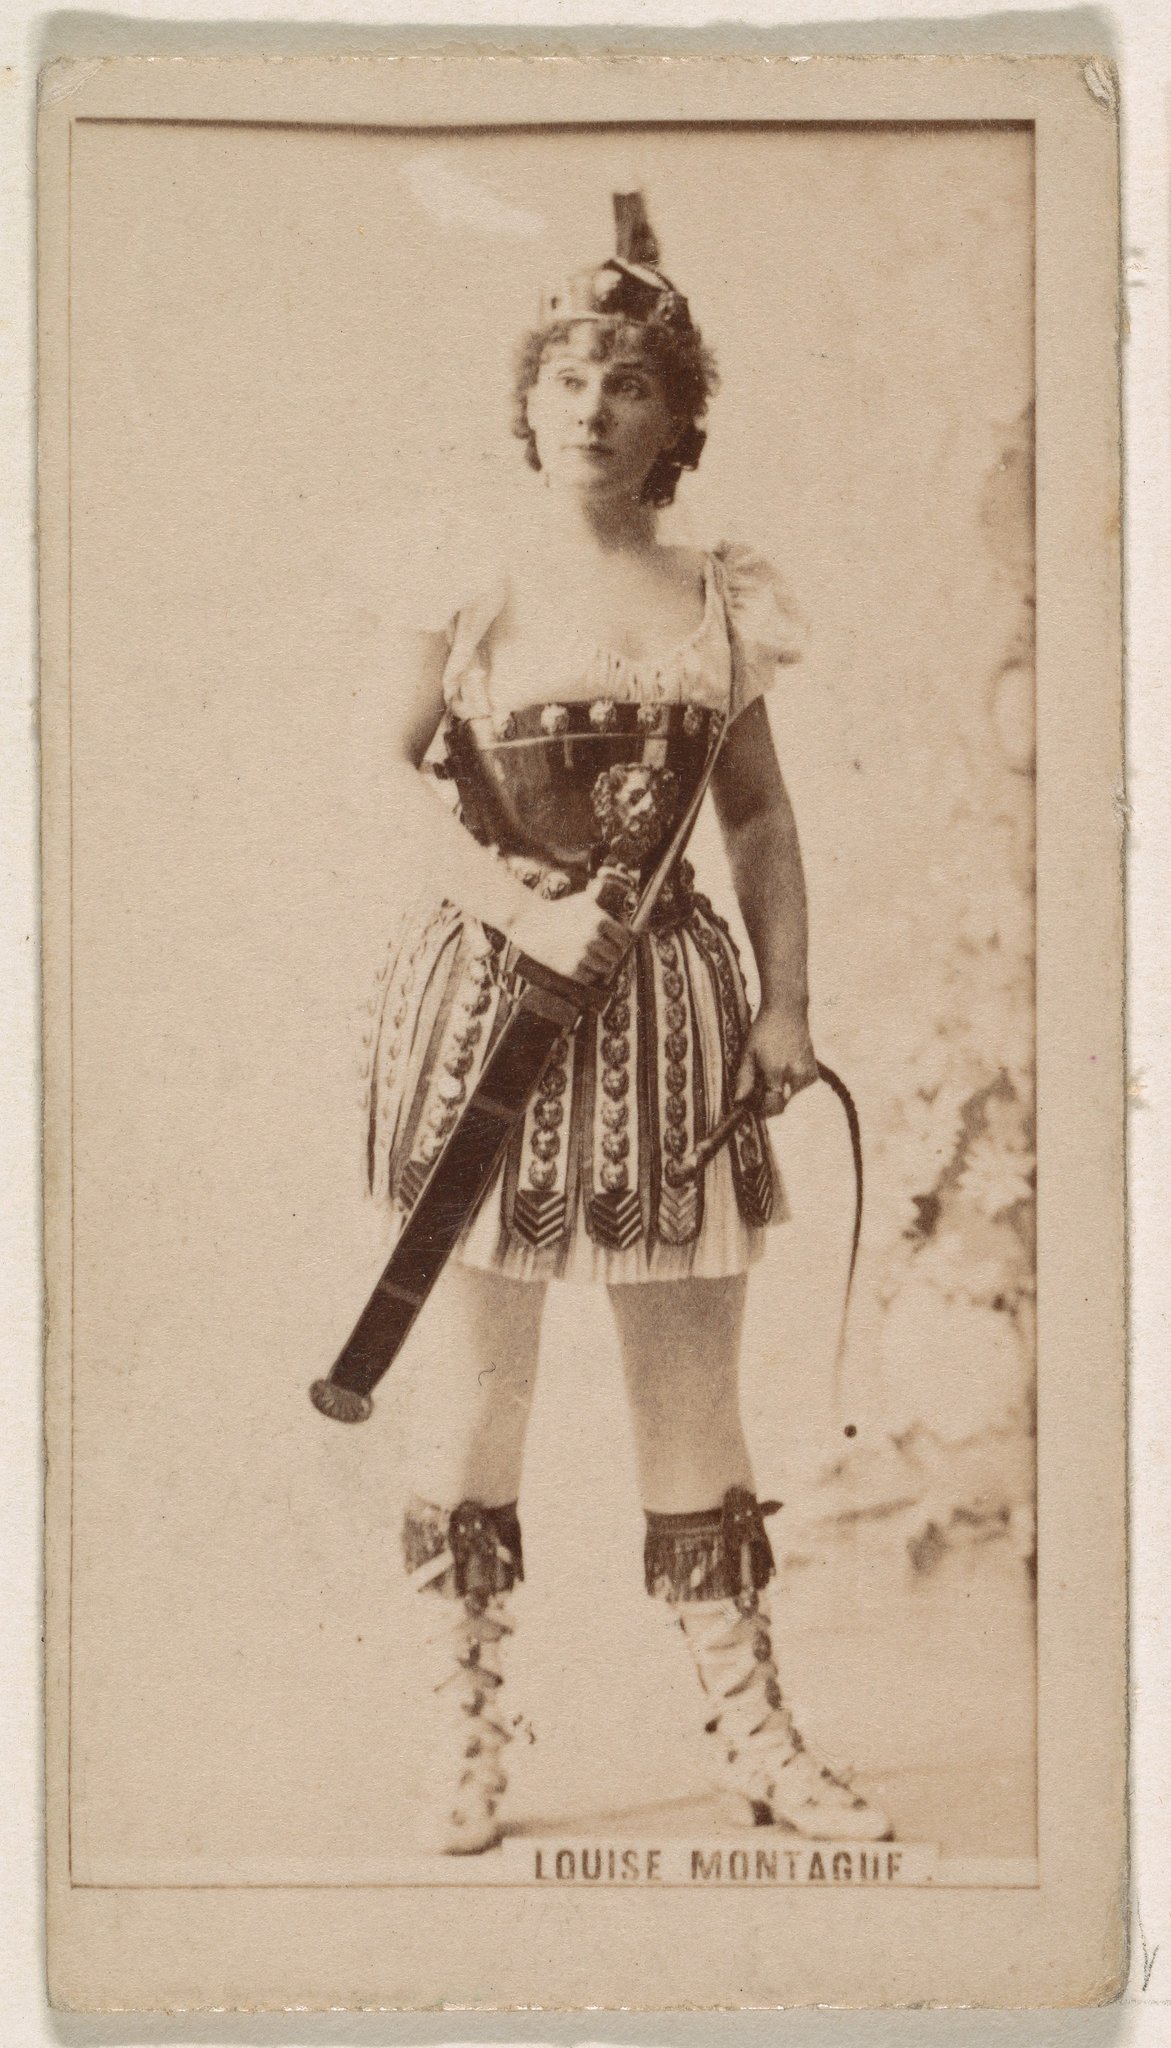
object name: photograph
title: Louise Montague, from the Actresses series (N245) issued by Kinney Brothers to promote Sweet Caporal Cigarettes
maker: kinney brothers tobacco company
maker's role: publisher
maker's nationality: american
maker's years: 1869-2011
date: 1890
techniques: albumen silver print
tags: portraits,women,actresses